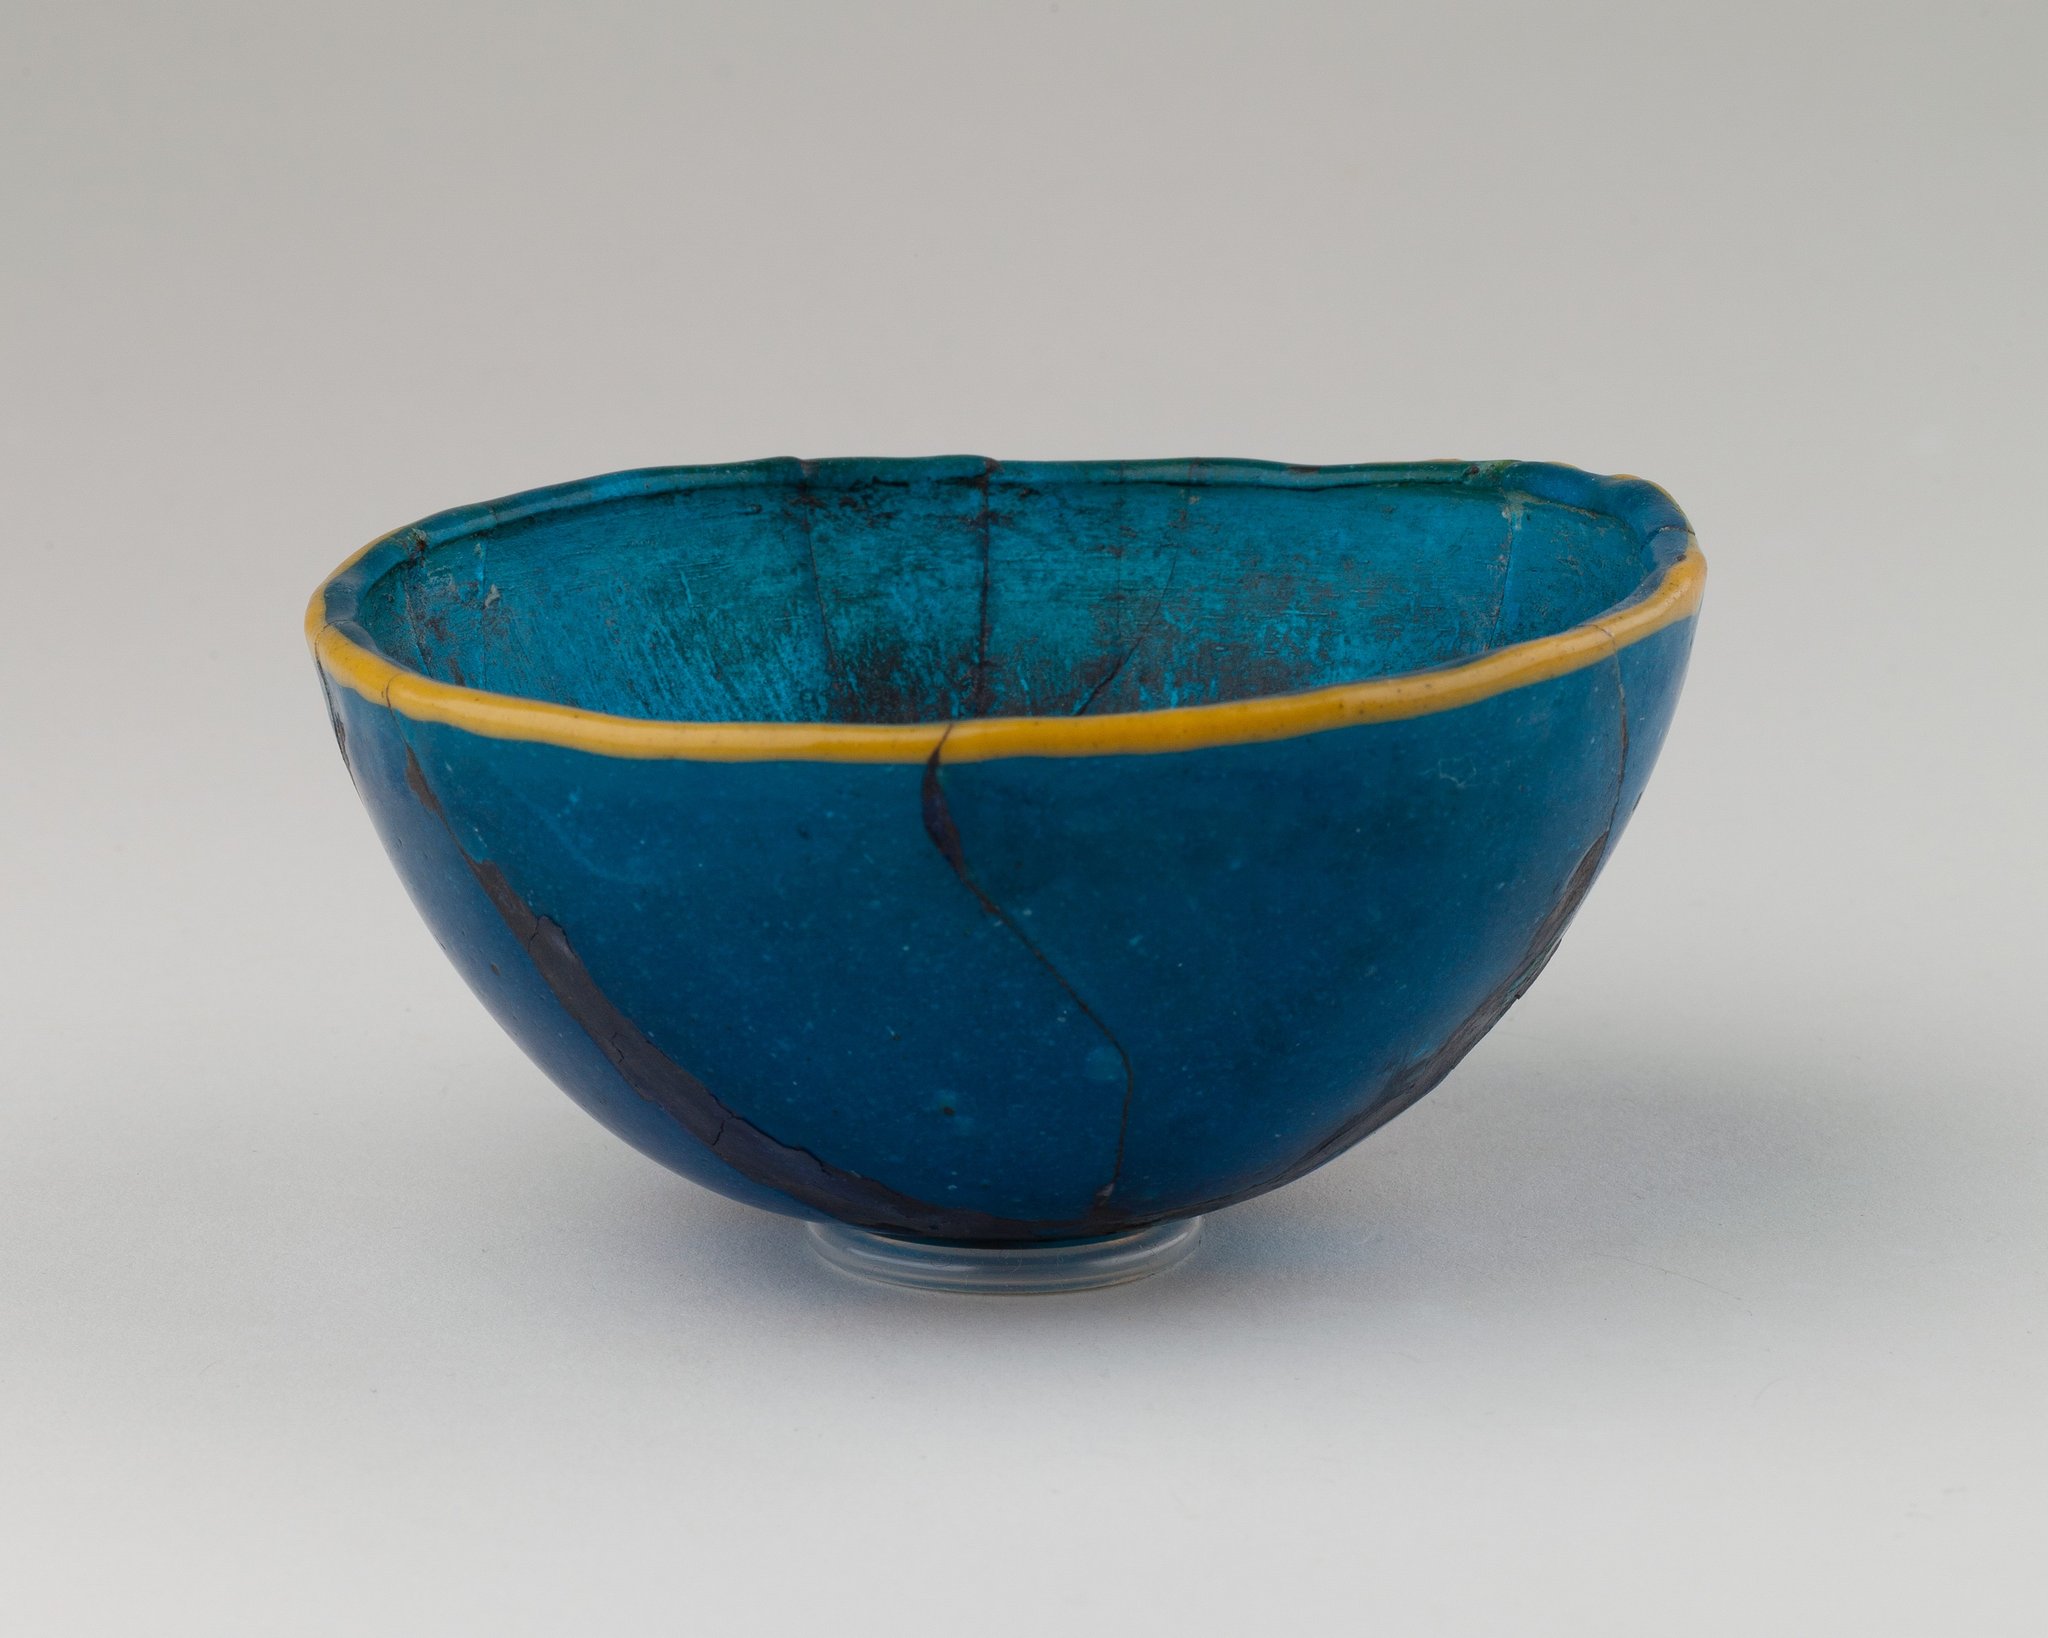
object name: bowl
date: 1295-1070 BCE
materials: glass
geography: egypt